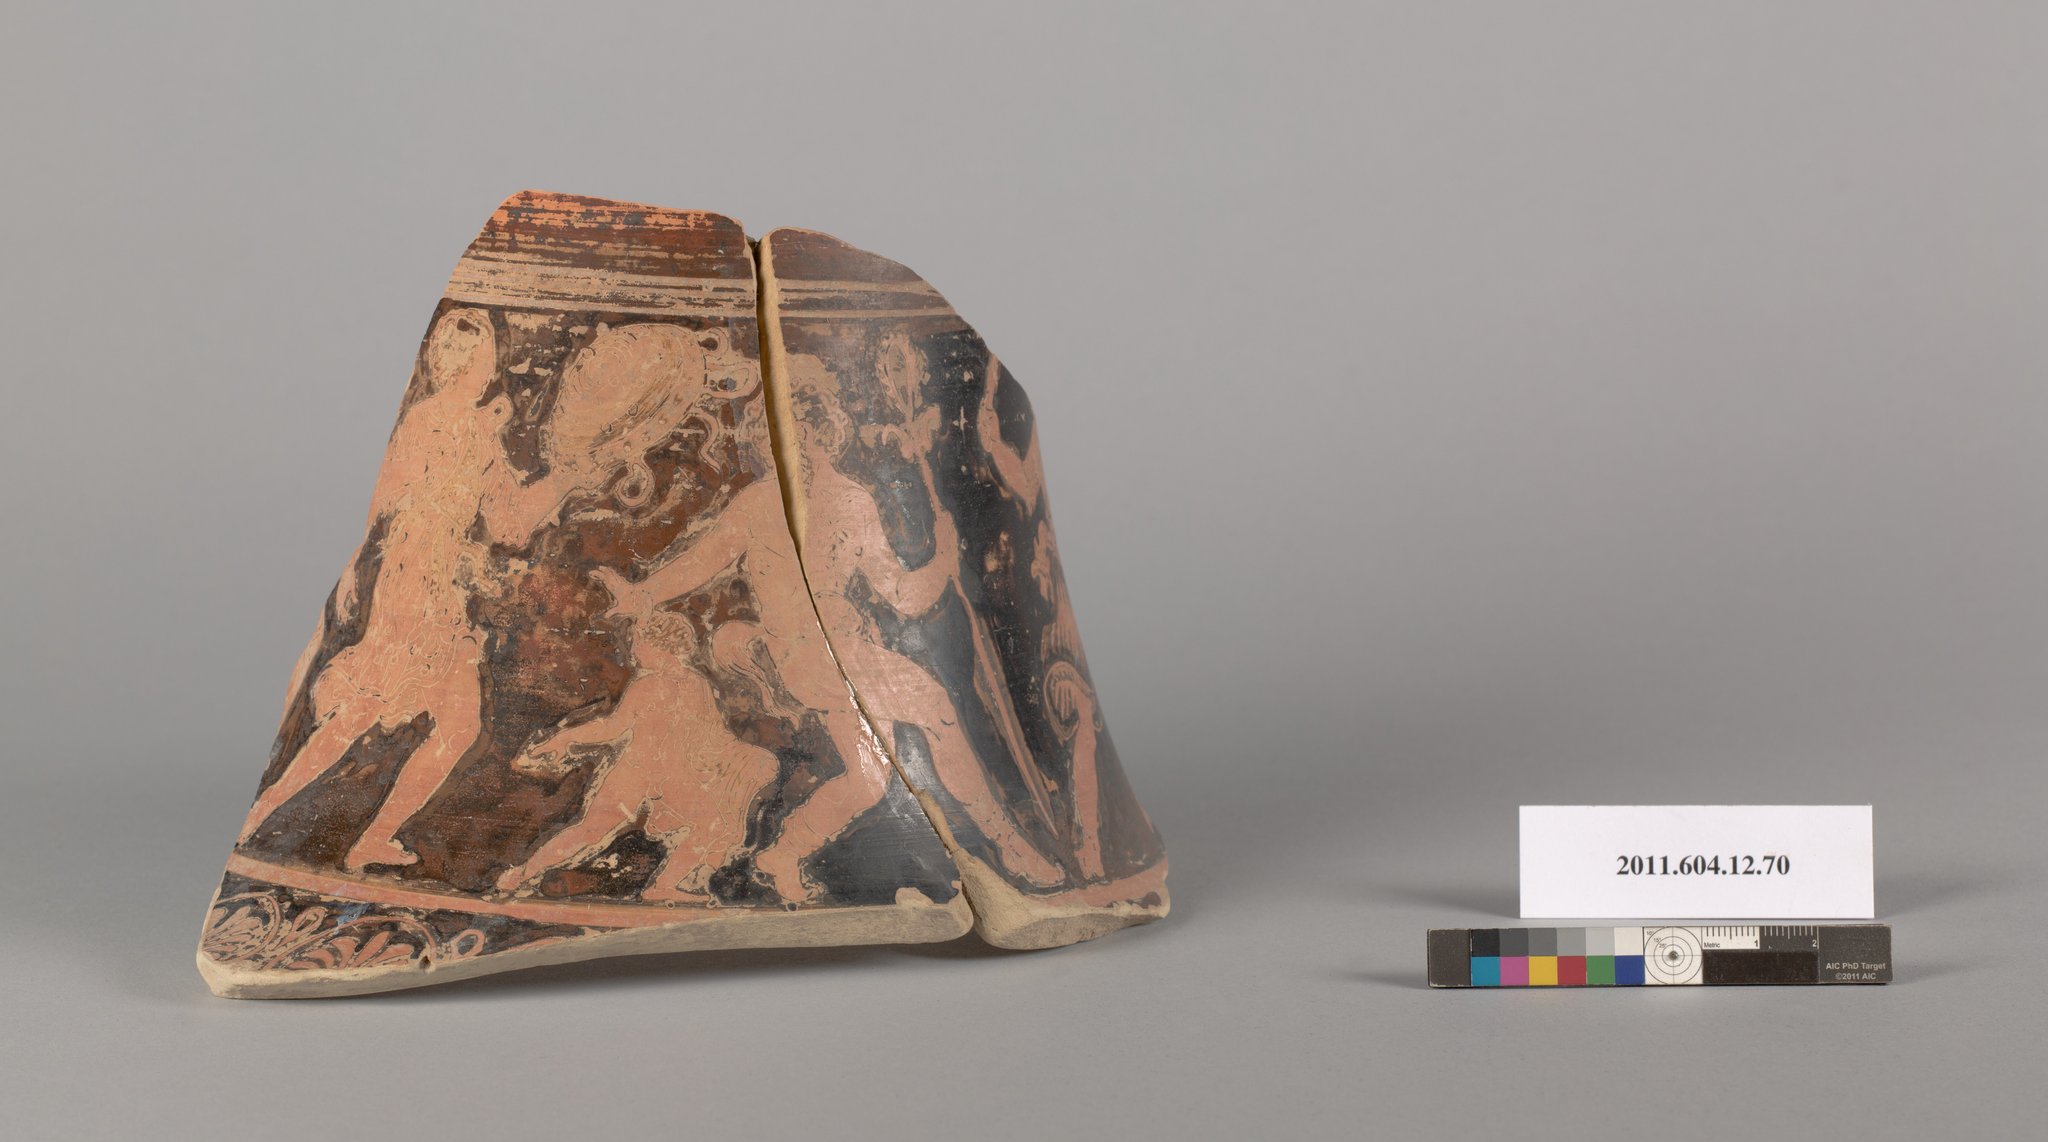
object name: undetermined closed shape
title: Terracotta fragment of a closed shape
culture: greek, sicilian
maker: sicilian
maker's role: artist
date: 370-350 BCE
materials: terracotta